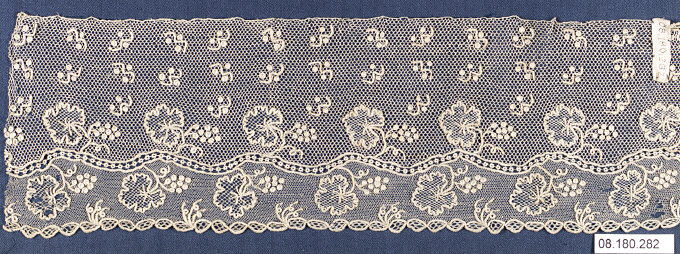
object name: fragment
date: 1701-1800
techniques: lace